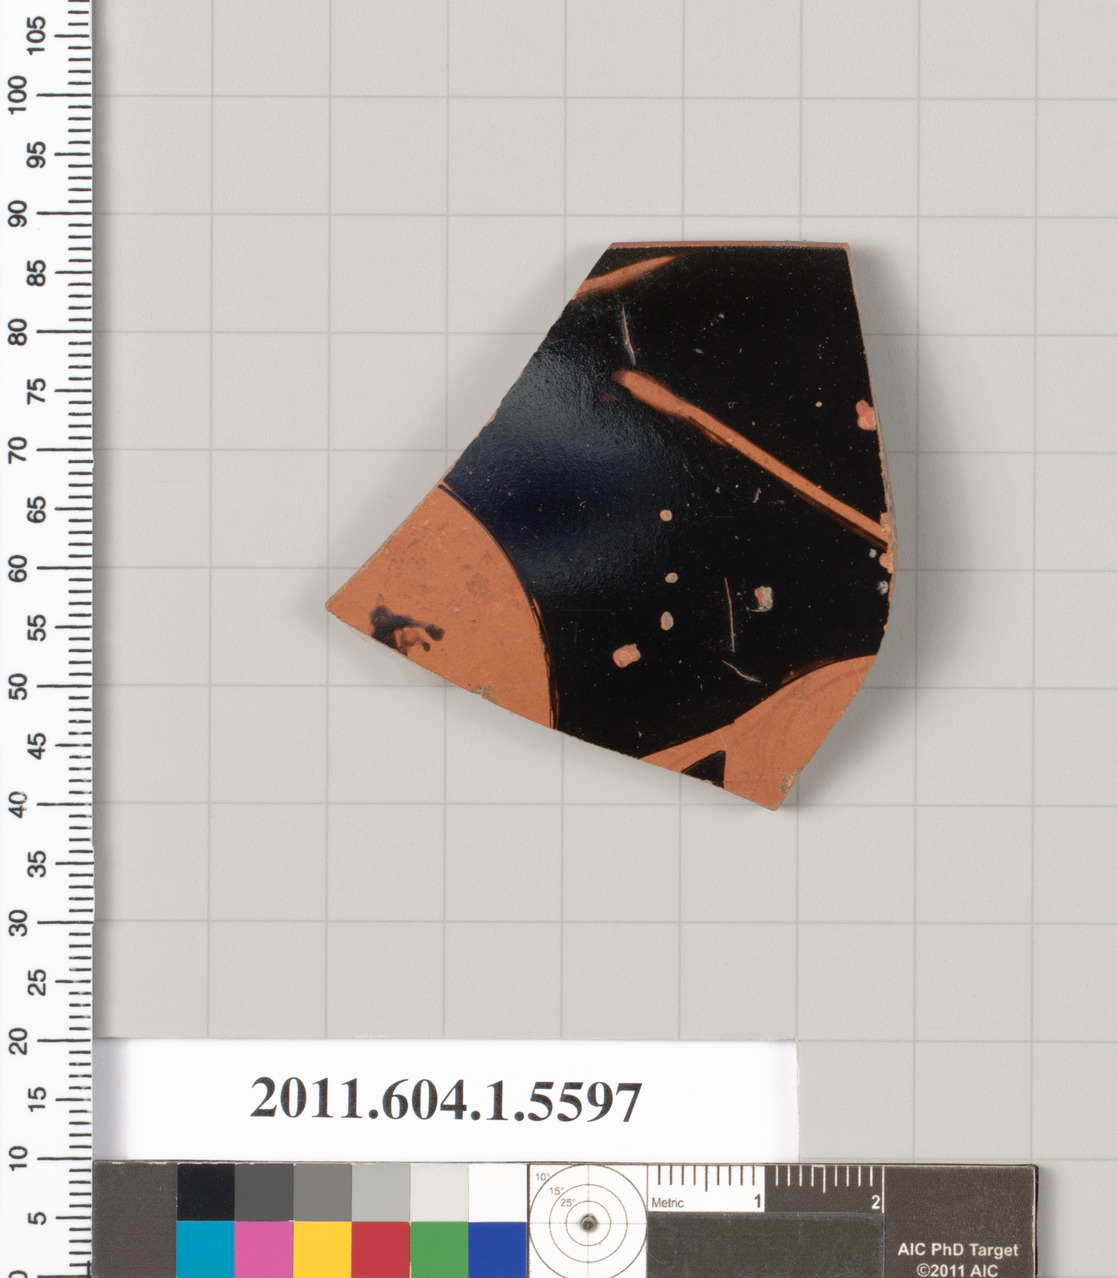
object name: kylix fragment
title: Terracotta rim fragment of a kylix (drinking cup)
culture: greek, attic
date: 500-490 BCE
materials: terracotta